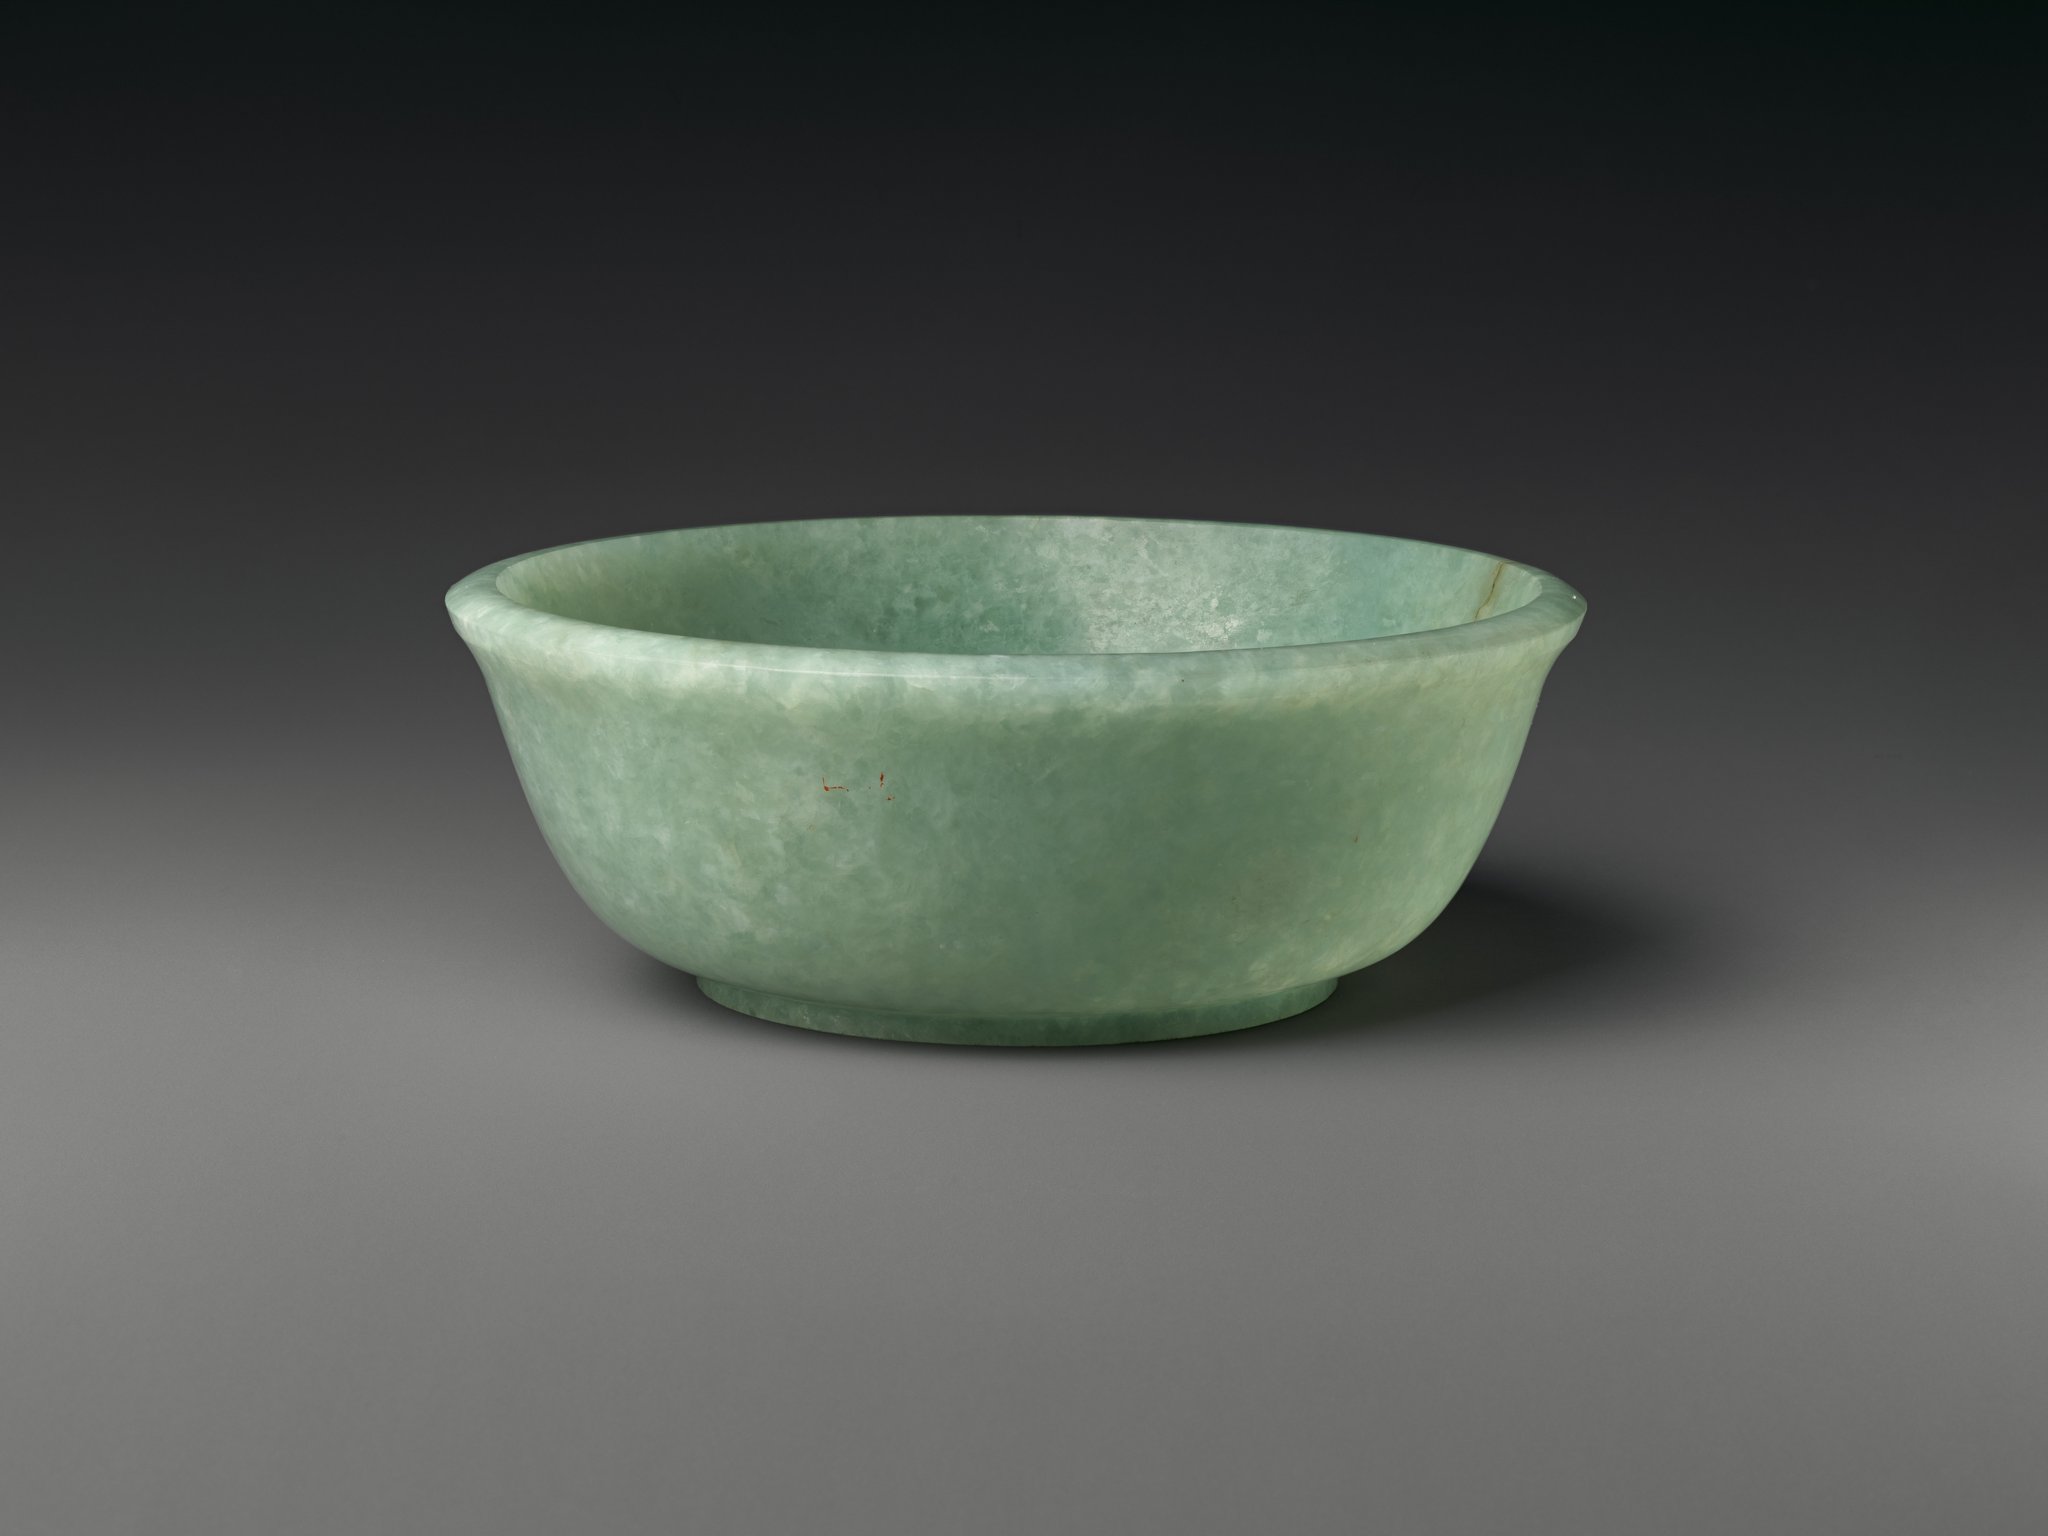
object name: bowl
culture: chinese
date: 1736-1795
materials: jade